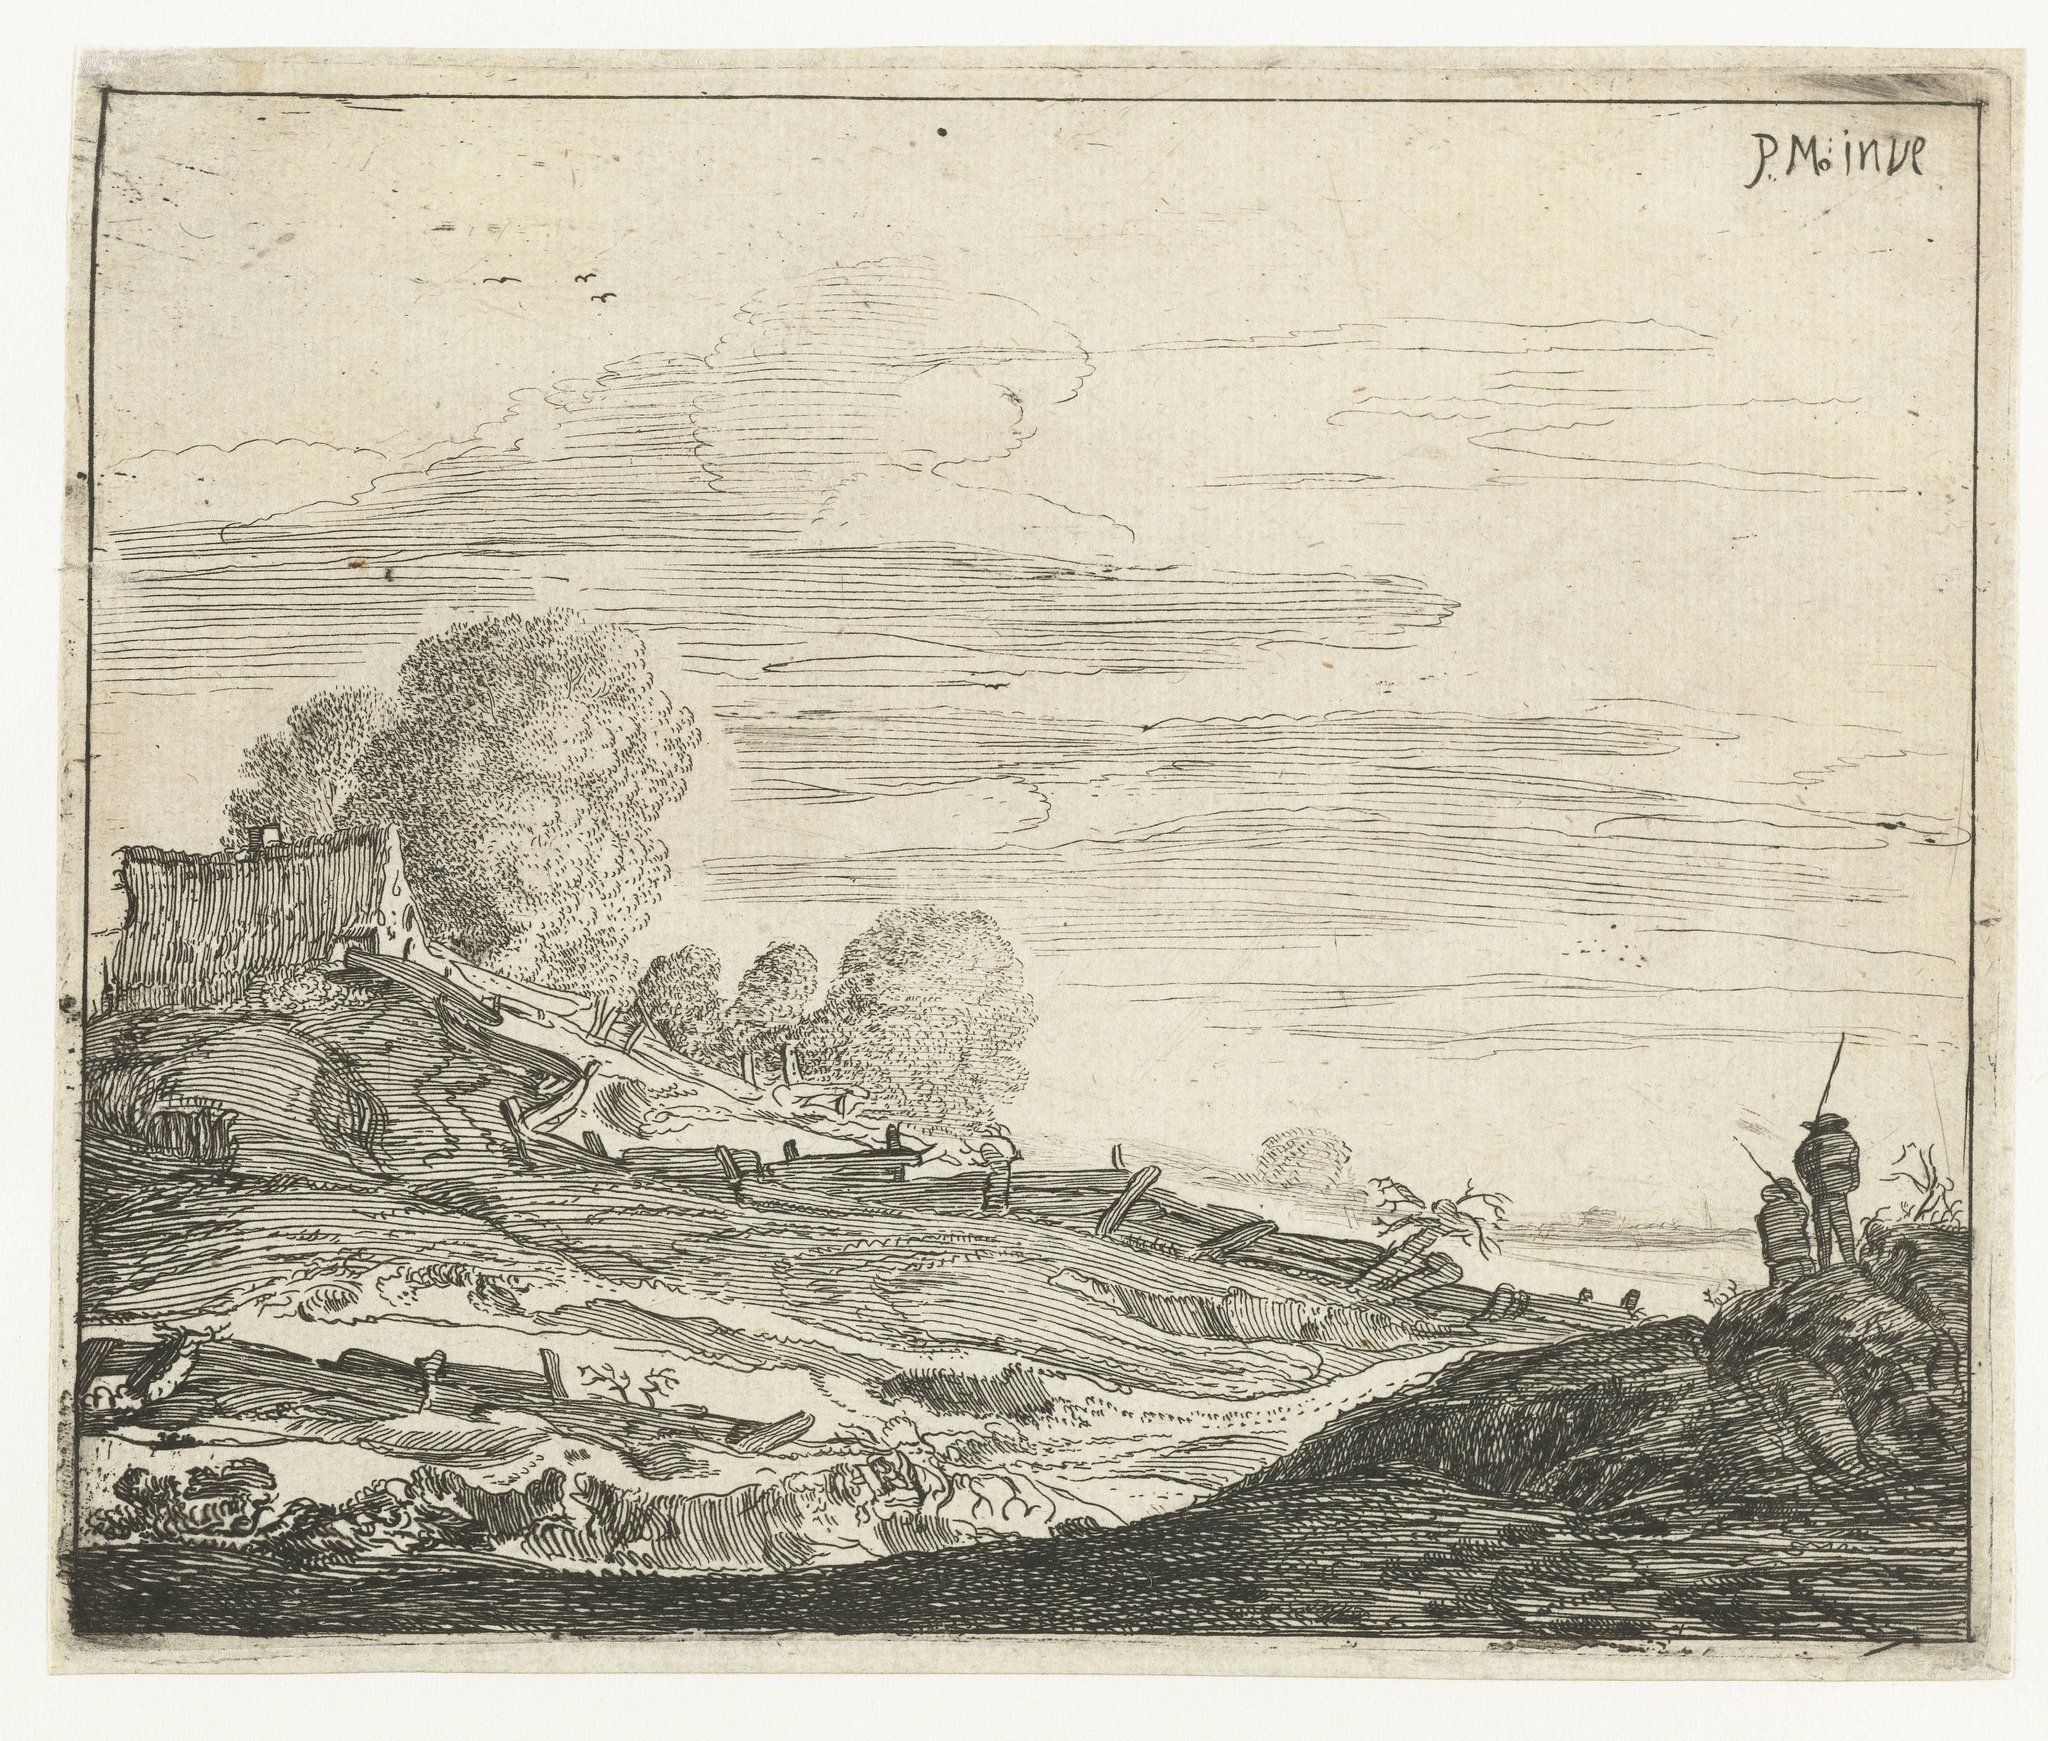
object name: print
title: Vier landschappen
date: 1623-1652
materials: paper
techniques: etching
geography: haarlem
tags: landscapes in the temperate zone, farm or solitary house in landscape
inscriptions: collector's mark: Lugt 2227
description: Landschap met uiterst links een huis op een heuvel. Rechts komen twee landlieden aangelopen. Deze prent is onderdeel van een serie van vier prenten van landschappen met landlieden in hoofd- of bijrol.